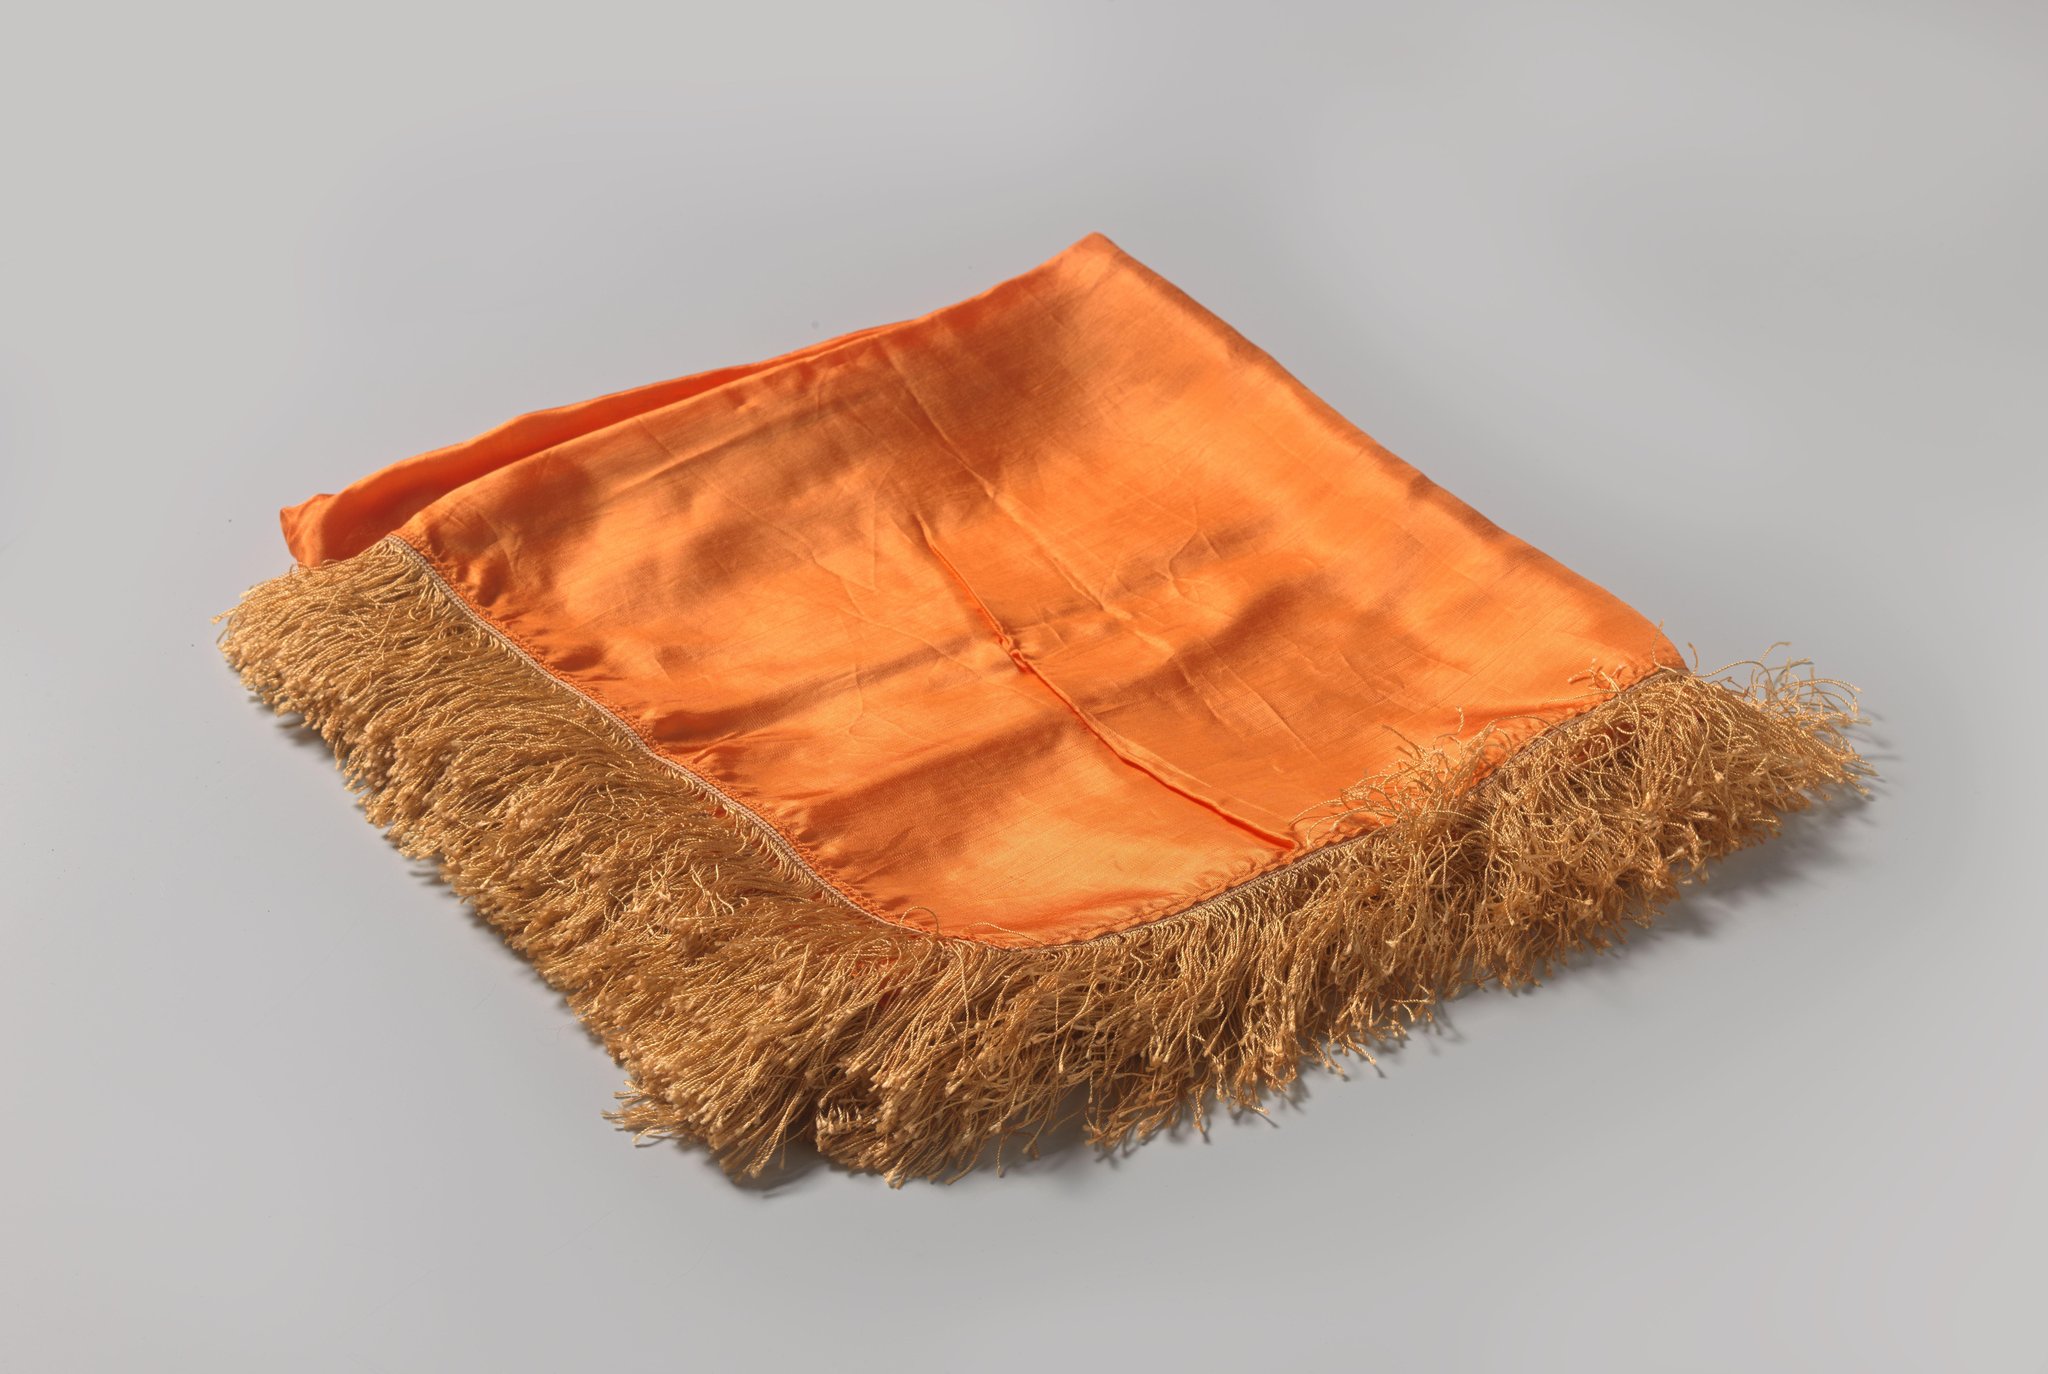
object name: sash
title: Sjerp behorend bij ambtskostuum van H.R. Rookmaker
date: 1933-1957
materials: cotton, silk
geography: surabaya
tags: dutch east indies, the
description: Oranje sjerp met franje behorend bij ambtskostuum van H.R. Rookmaker.